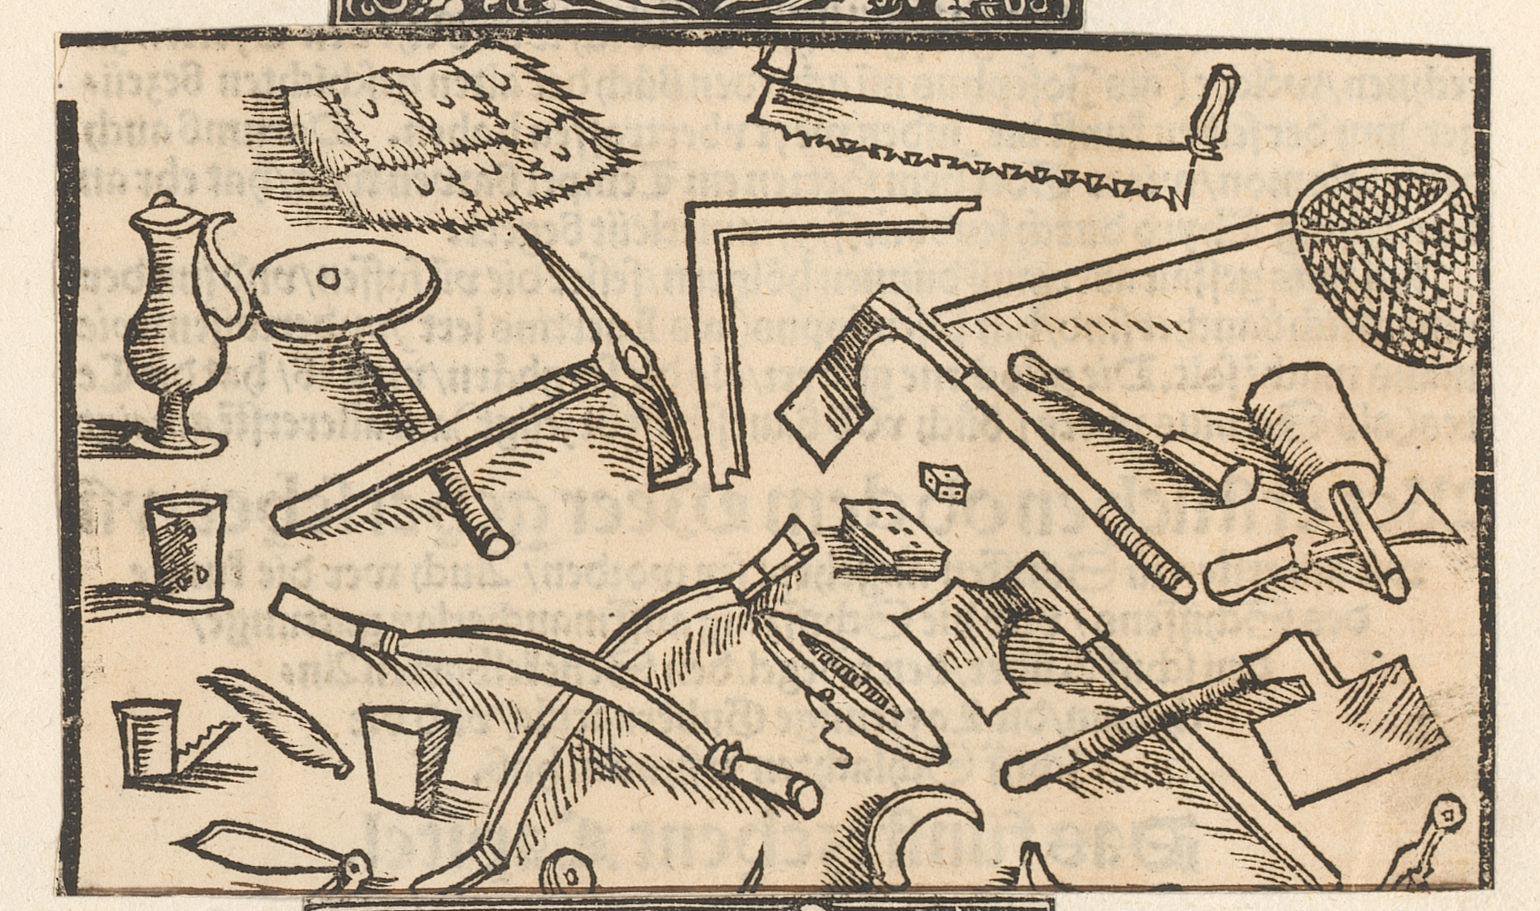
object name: print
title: Bouwgereedschap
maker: Anonymous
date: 1490-1534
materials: paper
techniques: letterpress printing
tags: tools and machines ~ building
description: Prent is gebruikt in: Teütsch Cicero. [Vertaald uit het Latijn door] Johannes von Schwarzenberg. Augsburg: Hans Steiner, 1534.